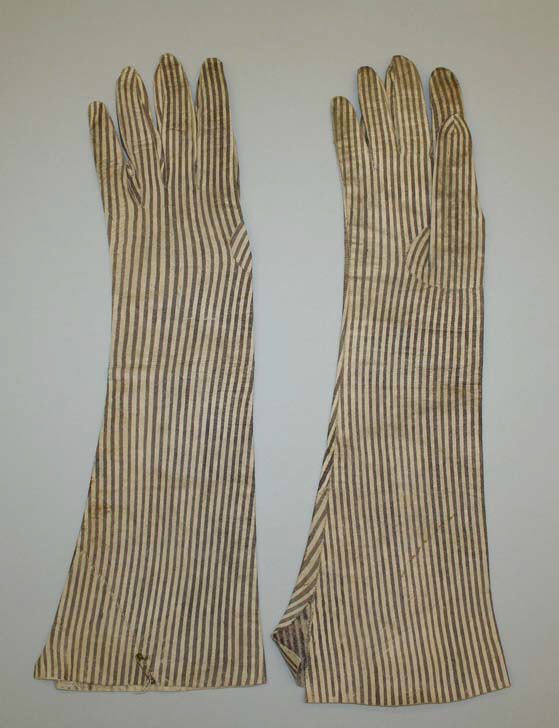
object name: glove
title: Gloves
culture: italian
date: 1767-1800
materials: leather